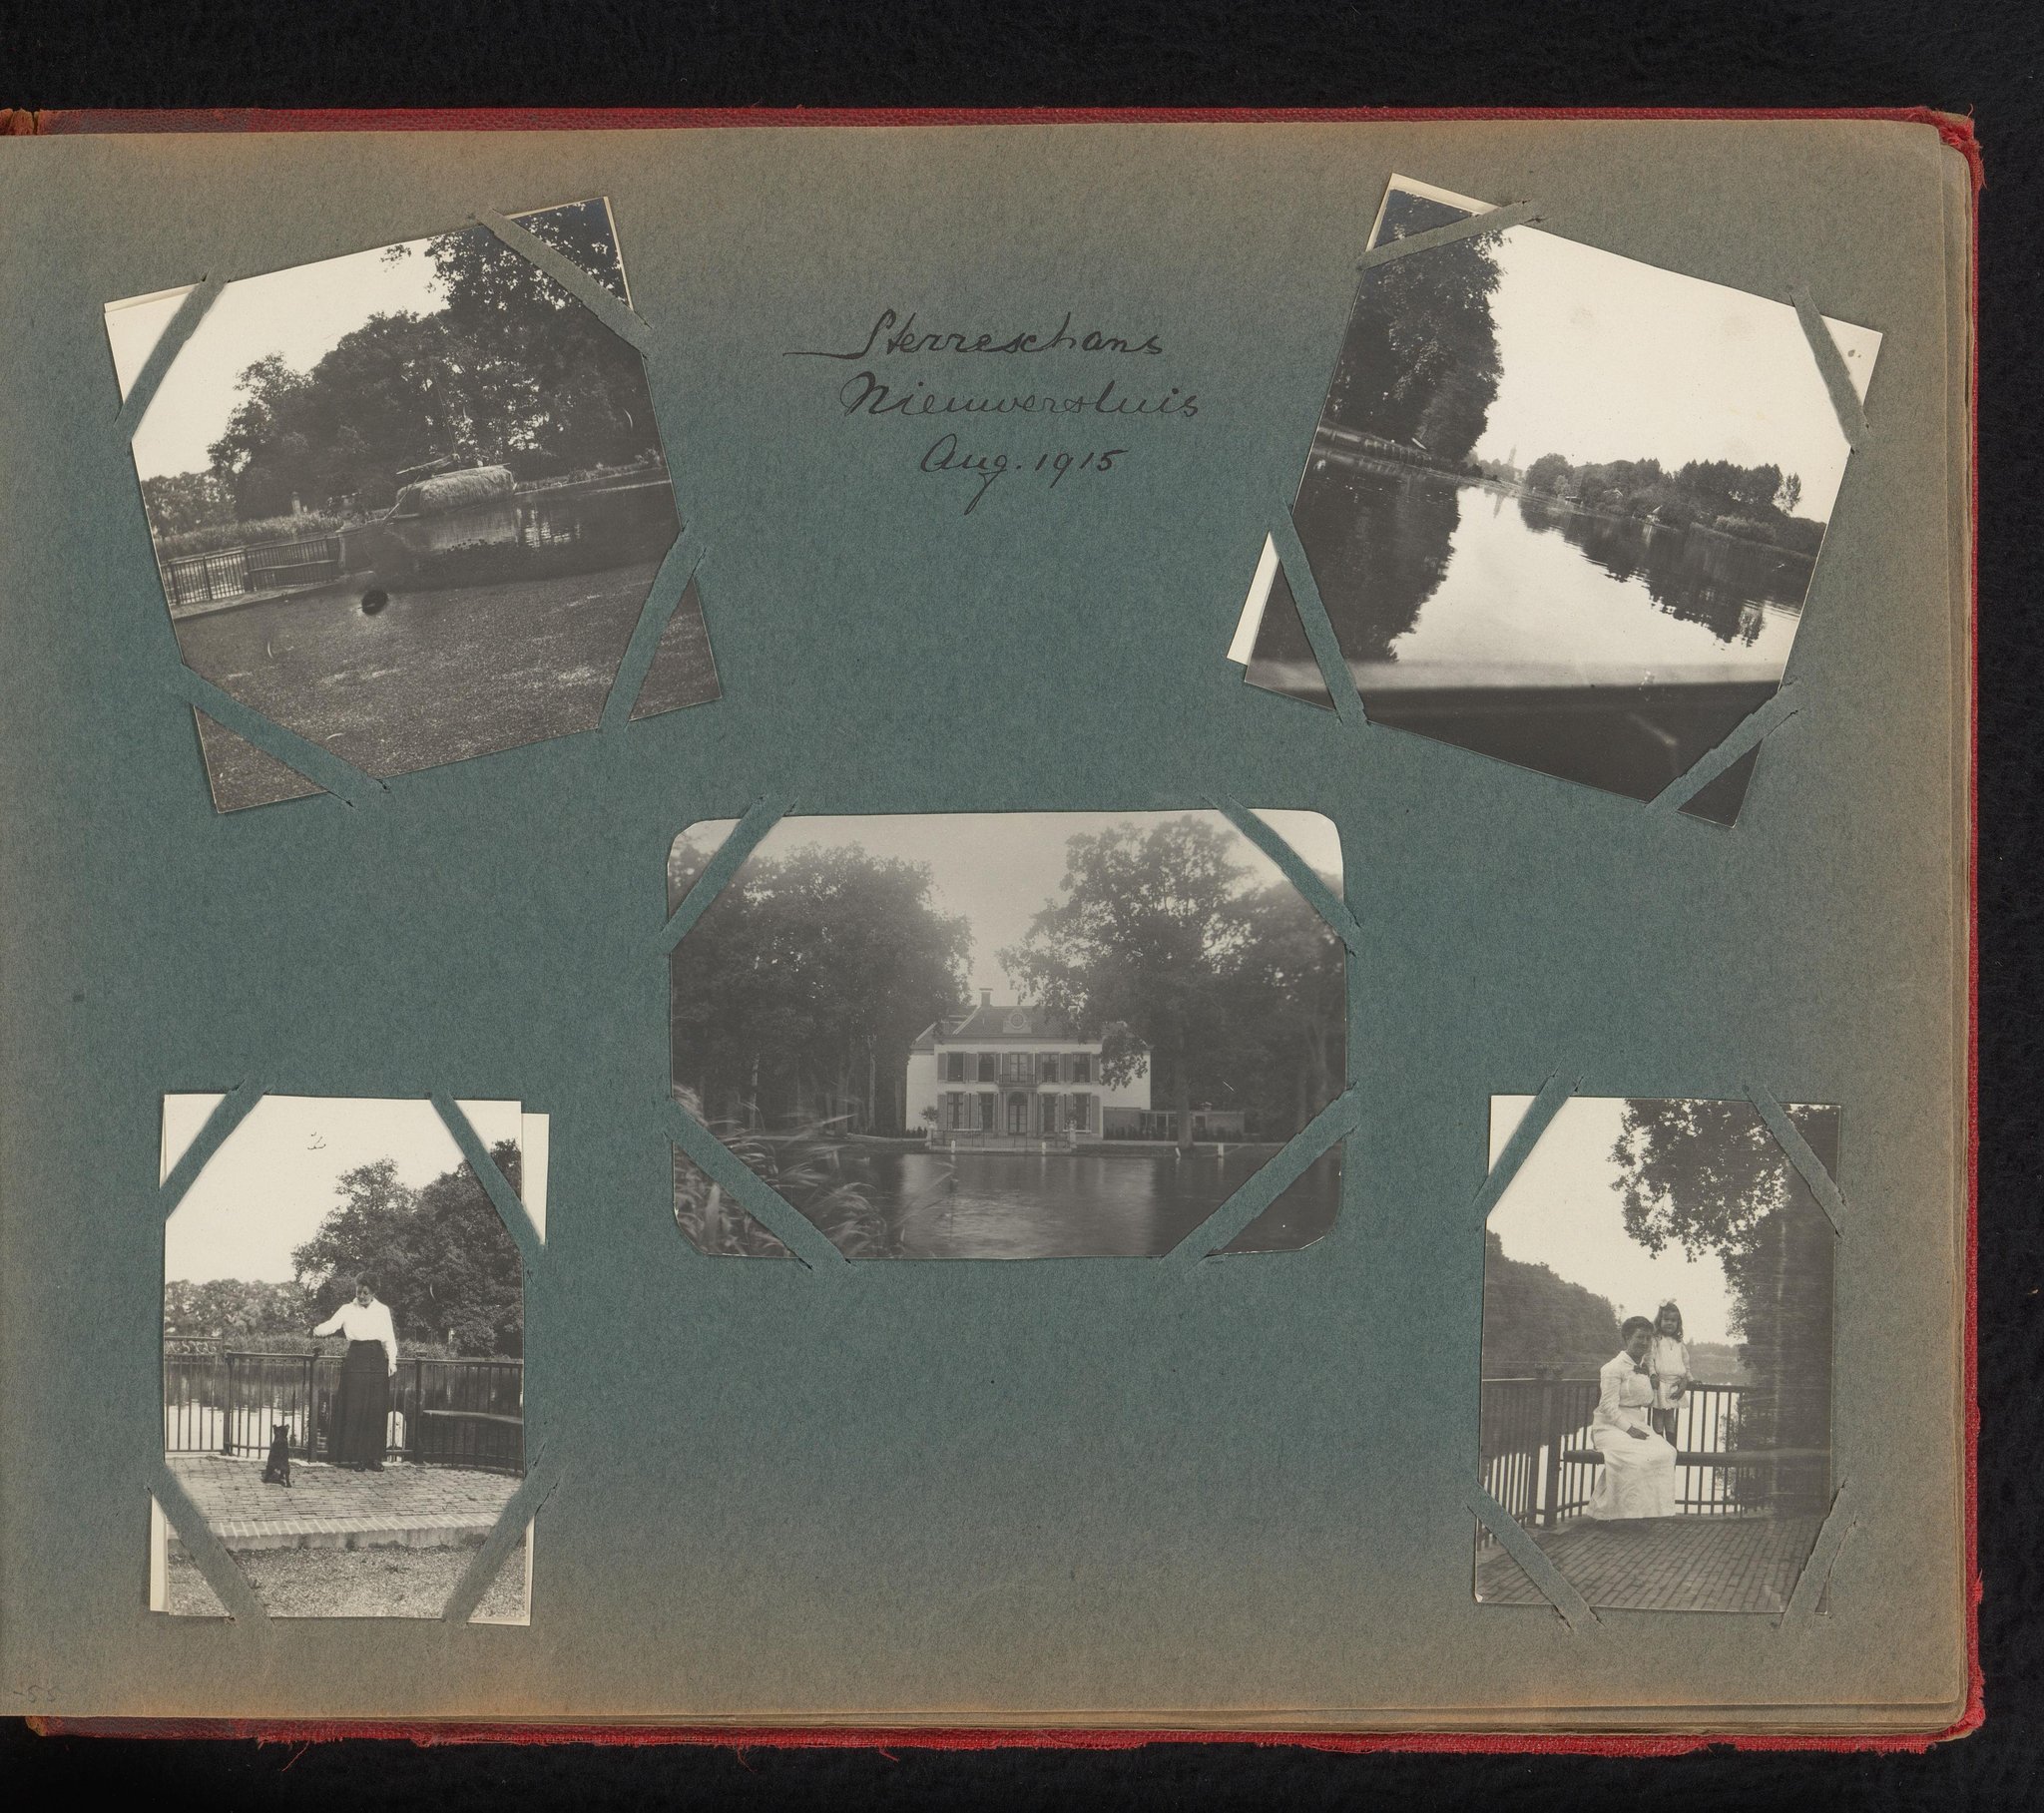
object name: photograph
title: Vijf gezichten op en vanuit buitenplaats Sterreschans in Nieuwersluis, onder een onbekende vrouw met hond en Eva Boelen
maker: charlotte alida boelen-matthes (lot)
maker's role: amateurfotograaf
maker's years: 1889-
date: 1908-1915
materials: paper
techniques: gelatin silver print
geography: nieuwersluis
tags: amsterdam, eva charlotte pennink-boelen, adult woman, girl (child between toddler and youth), villa, dog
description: Deze foto's zijn onderdeel van een album.